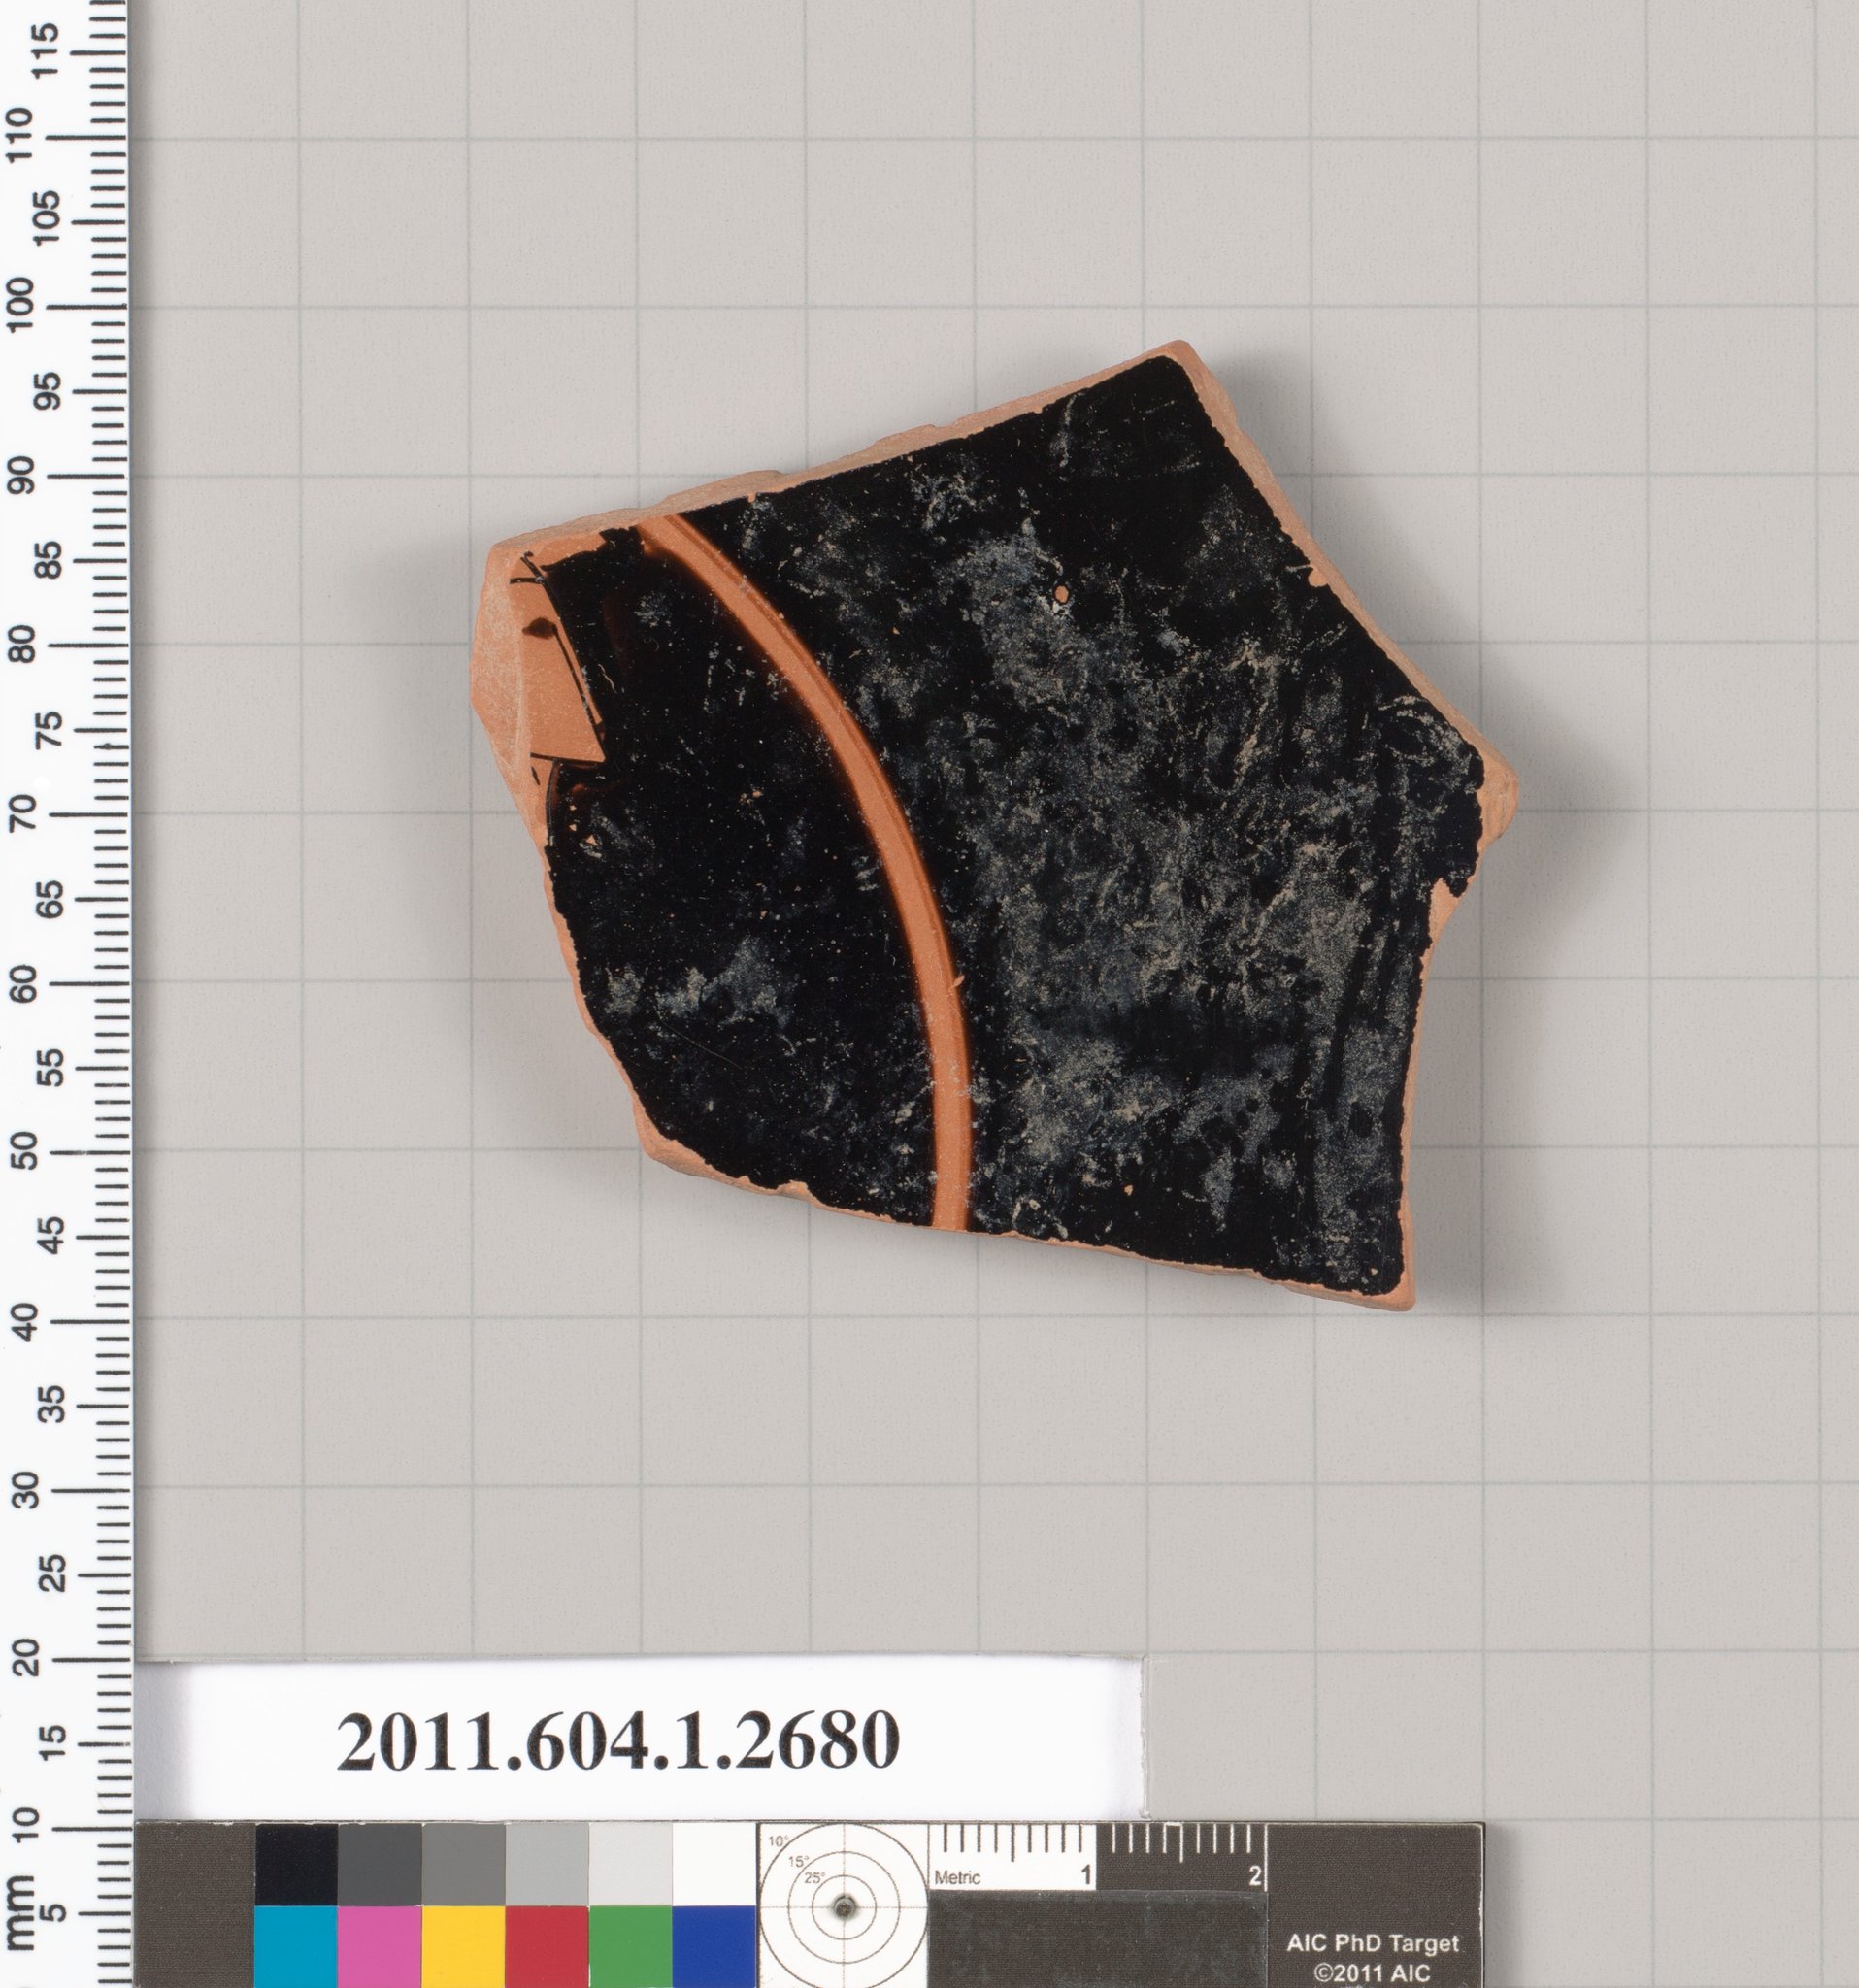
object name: kylix fragment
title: Terracotta fragment of a kylix (drinking cup)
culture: greek, attic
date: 500-490 BCE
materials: terracotta